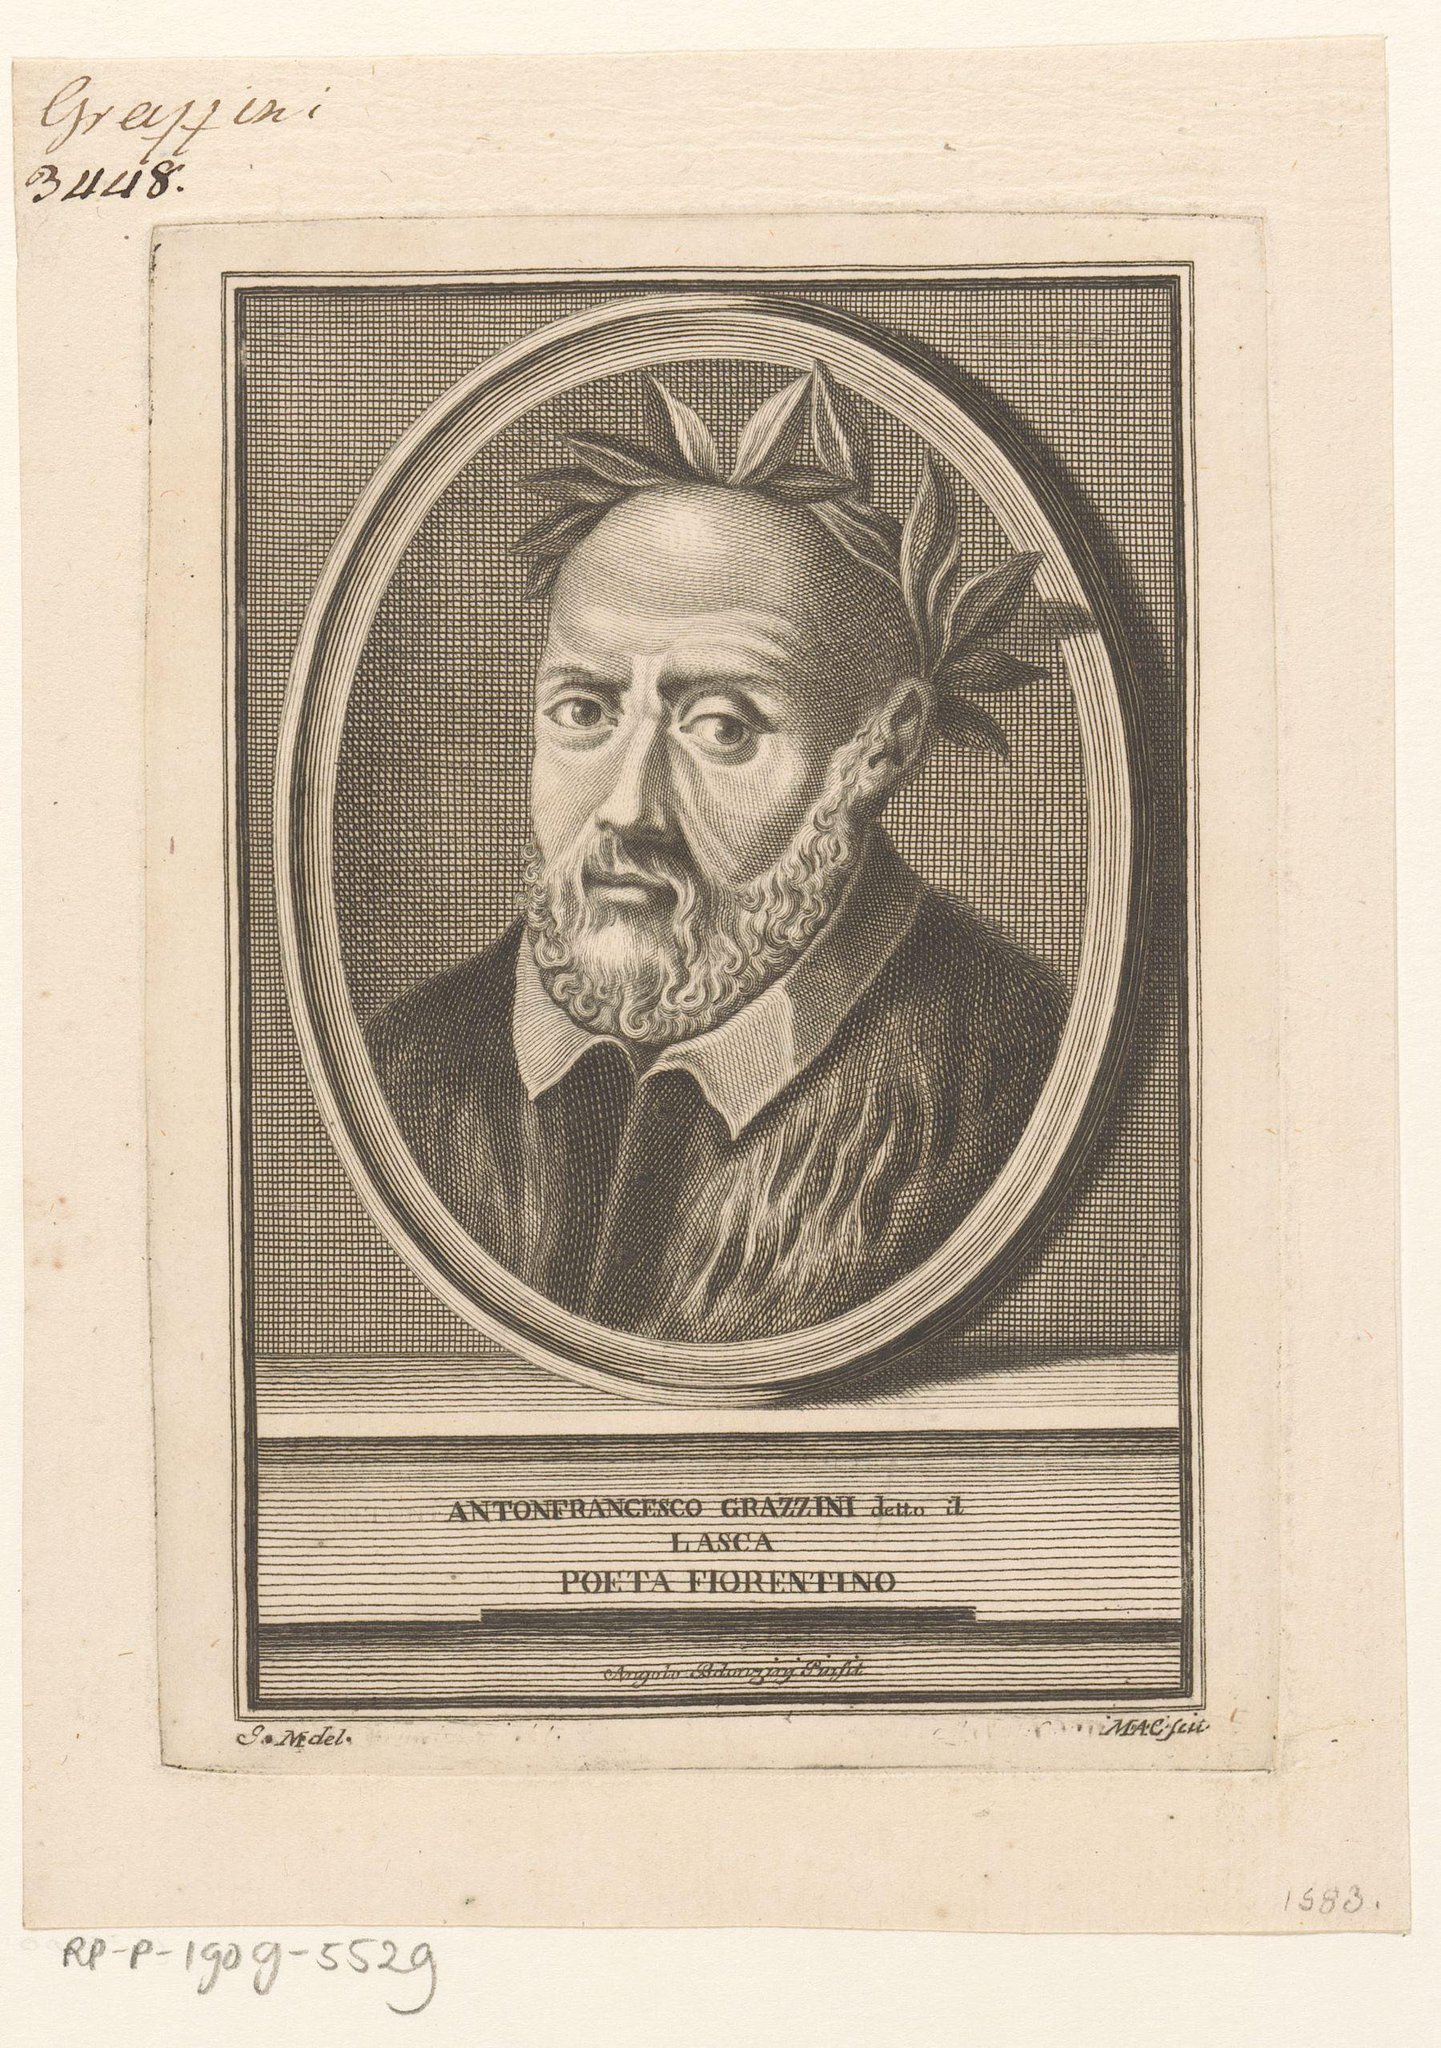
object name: book illustration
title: Portretten van schrijvers die liederen schreven voor Lorenzo de'Medici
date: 1750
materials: paper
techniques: engraving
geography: italy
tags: historical persons, portrait of a writer, writer, poet, author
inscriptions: inscription: ‘Grazzini / 3448’, collector's mark: Lugt 2228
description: Prent gebruikt voor Grazzini, Anton Francesco. Tutti i trionfi, carri, mascherate o canti carnascialeschi andati per Firenze dal tempo del Magnifico Lorenzo de' Medici fino all' anno 1559 : in questa seconda edizione corretti, con diversi MSS. collazionati, delle loro varie lezioni arricchiti, notabilmente accresciuti, e co' ritratti di ciascun poeta adornate. Lucca: Cosmopoli, 1750.